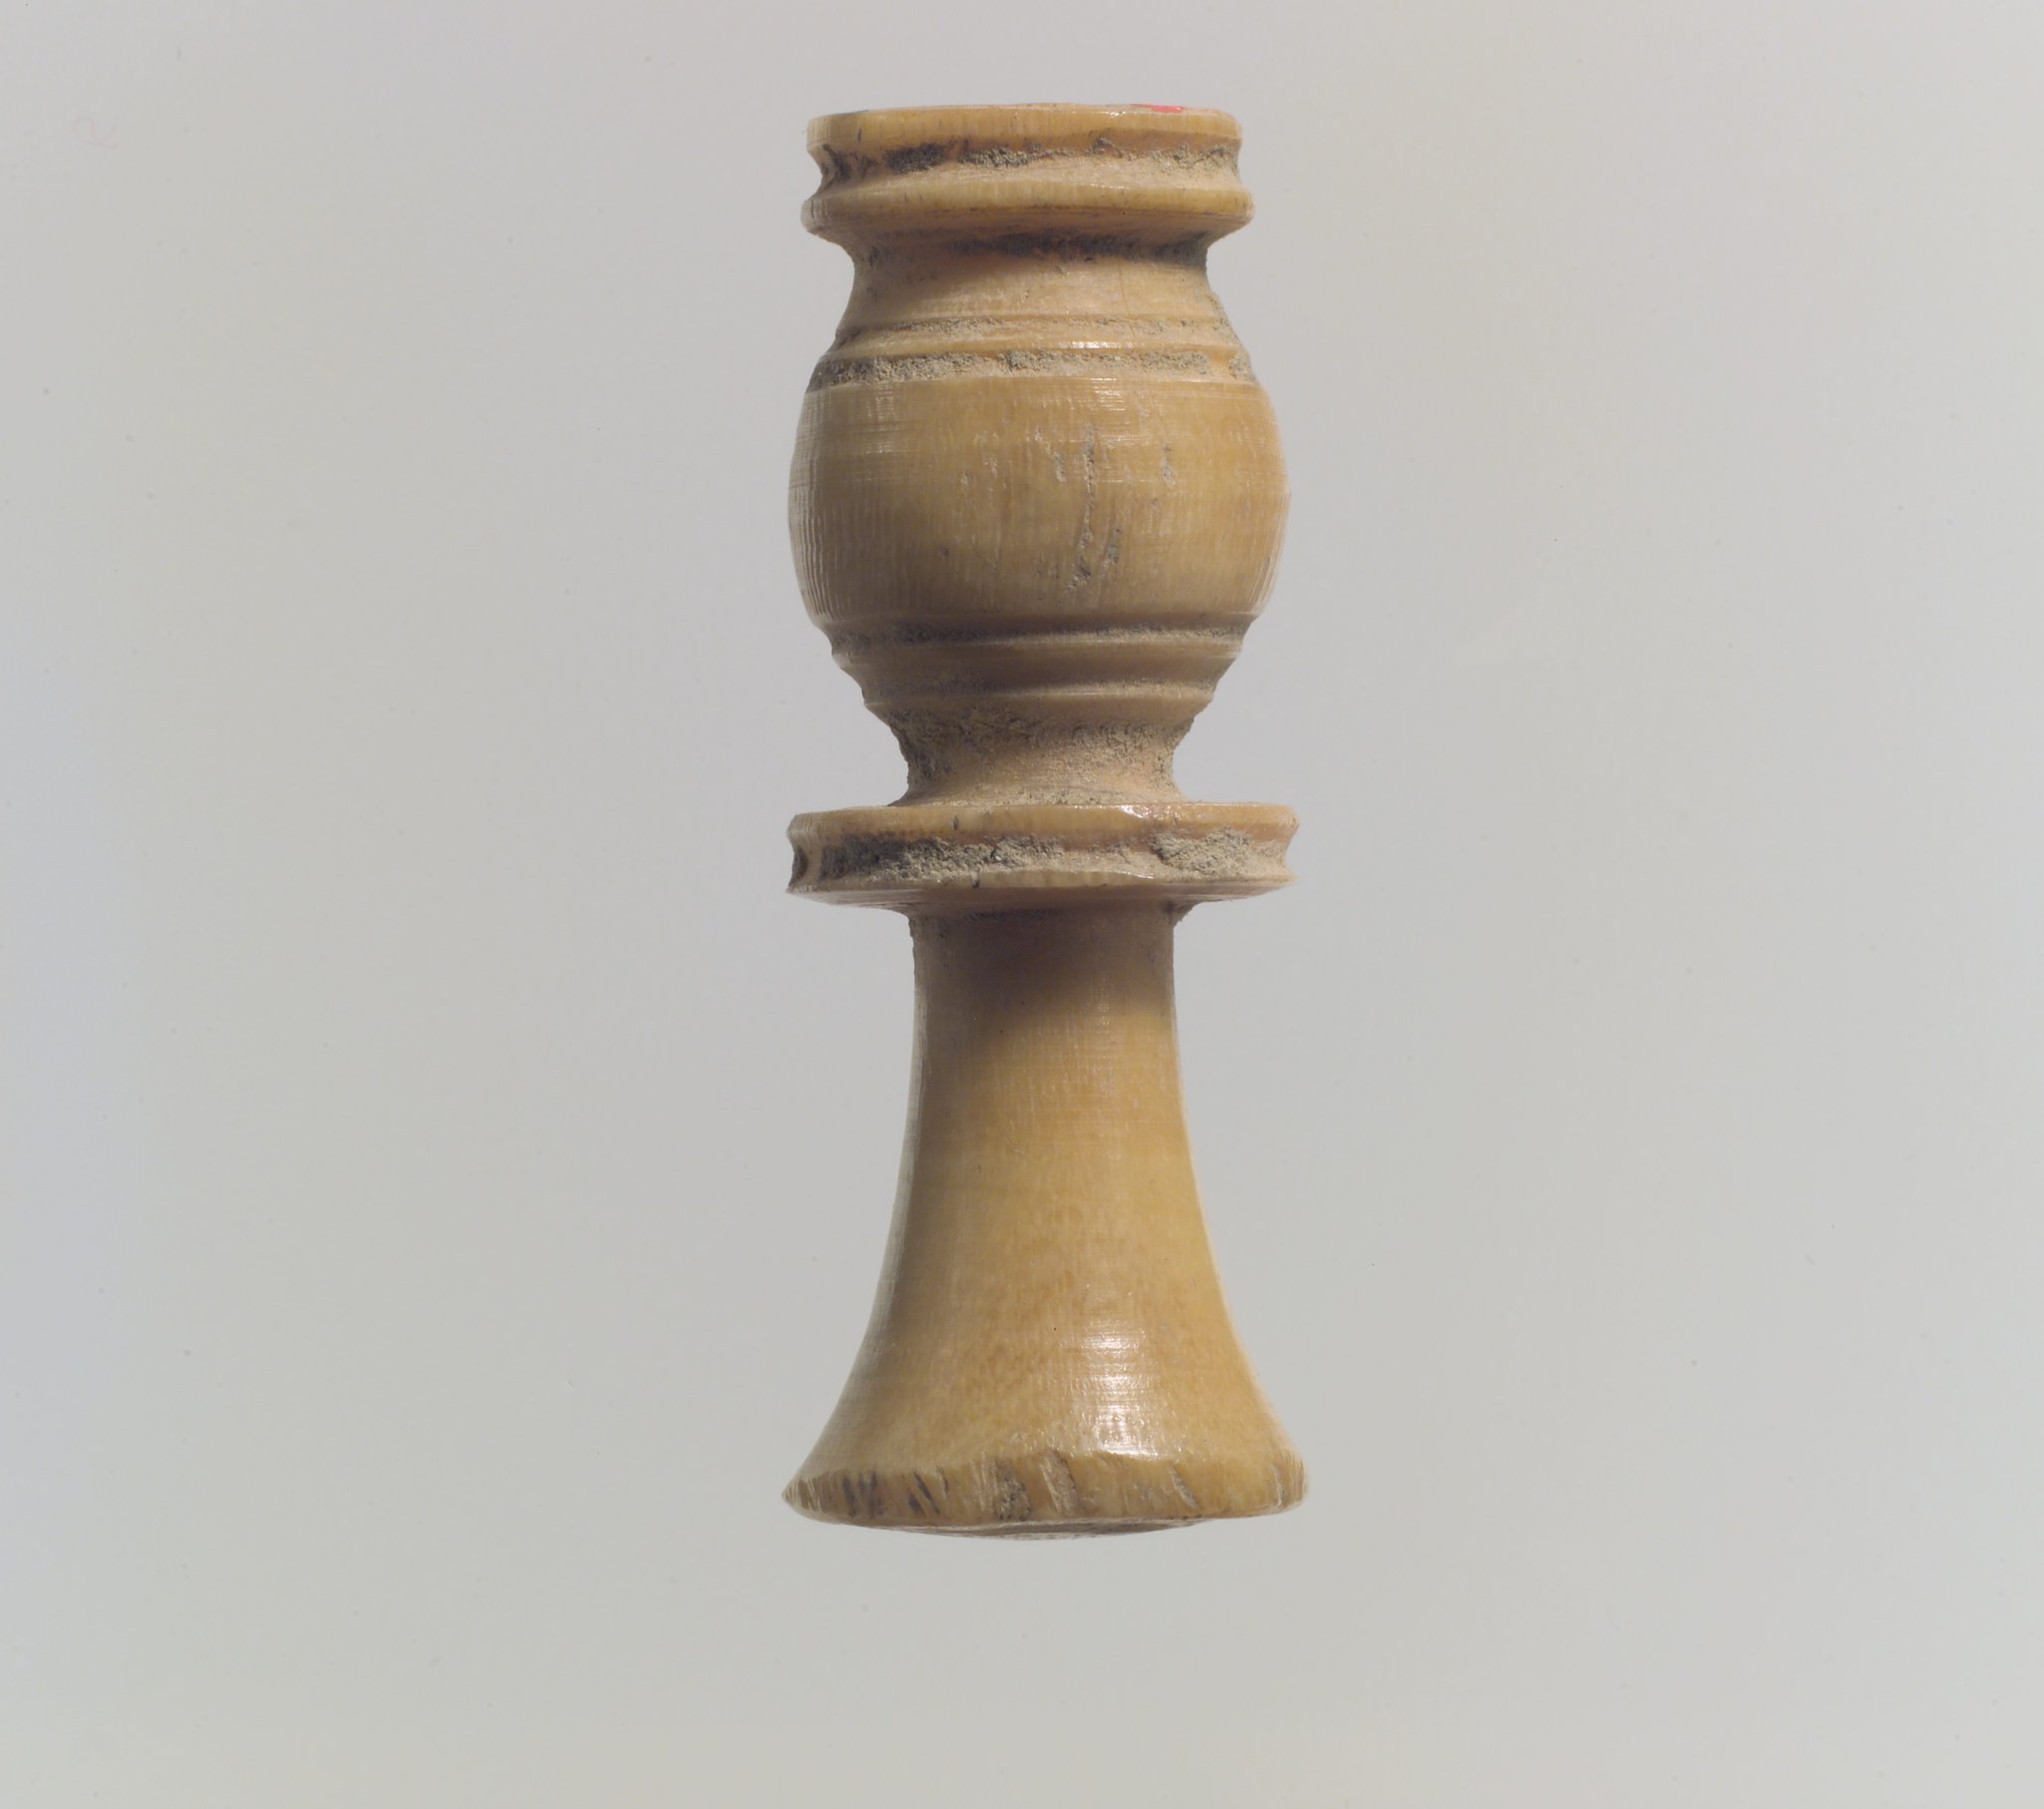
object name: handle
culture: sasanian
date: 201-700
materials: ivory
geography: mesopotamia